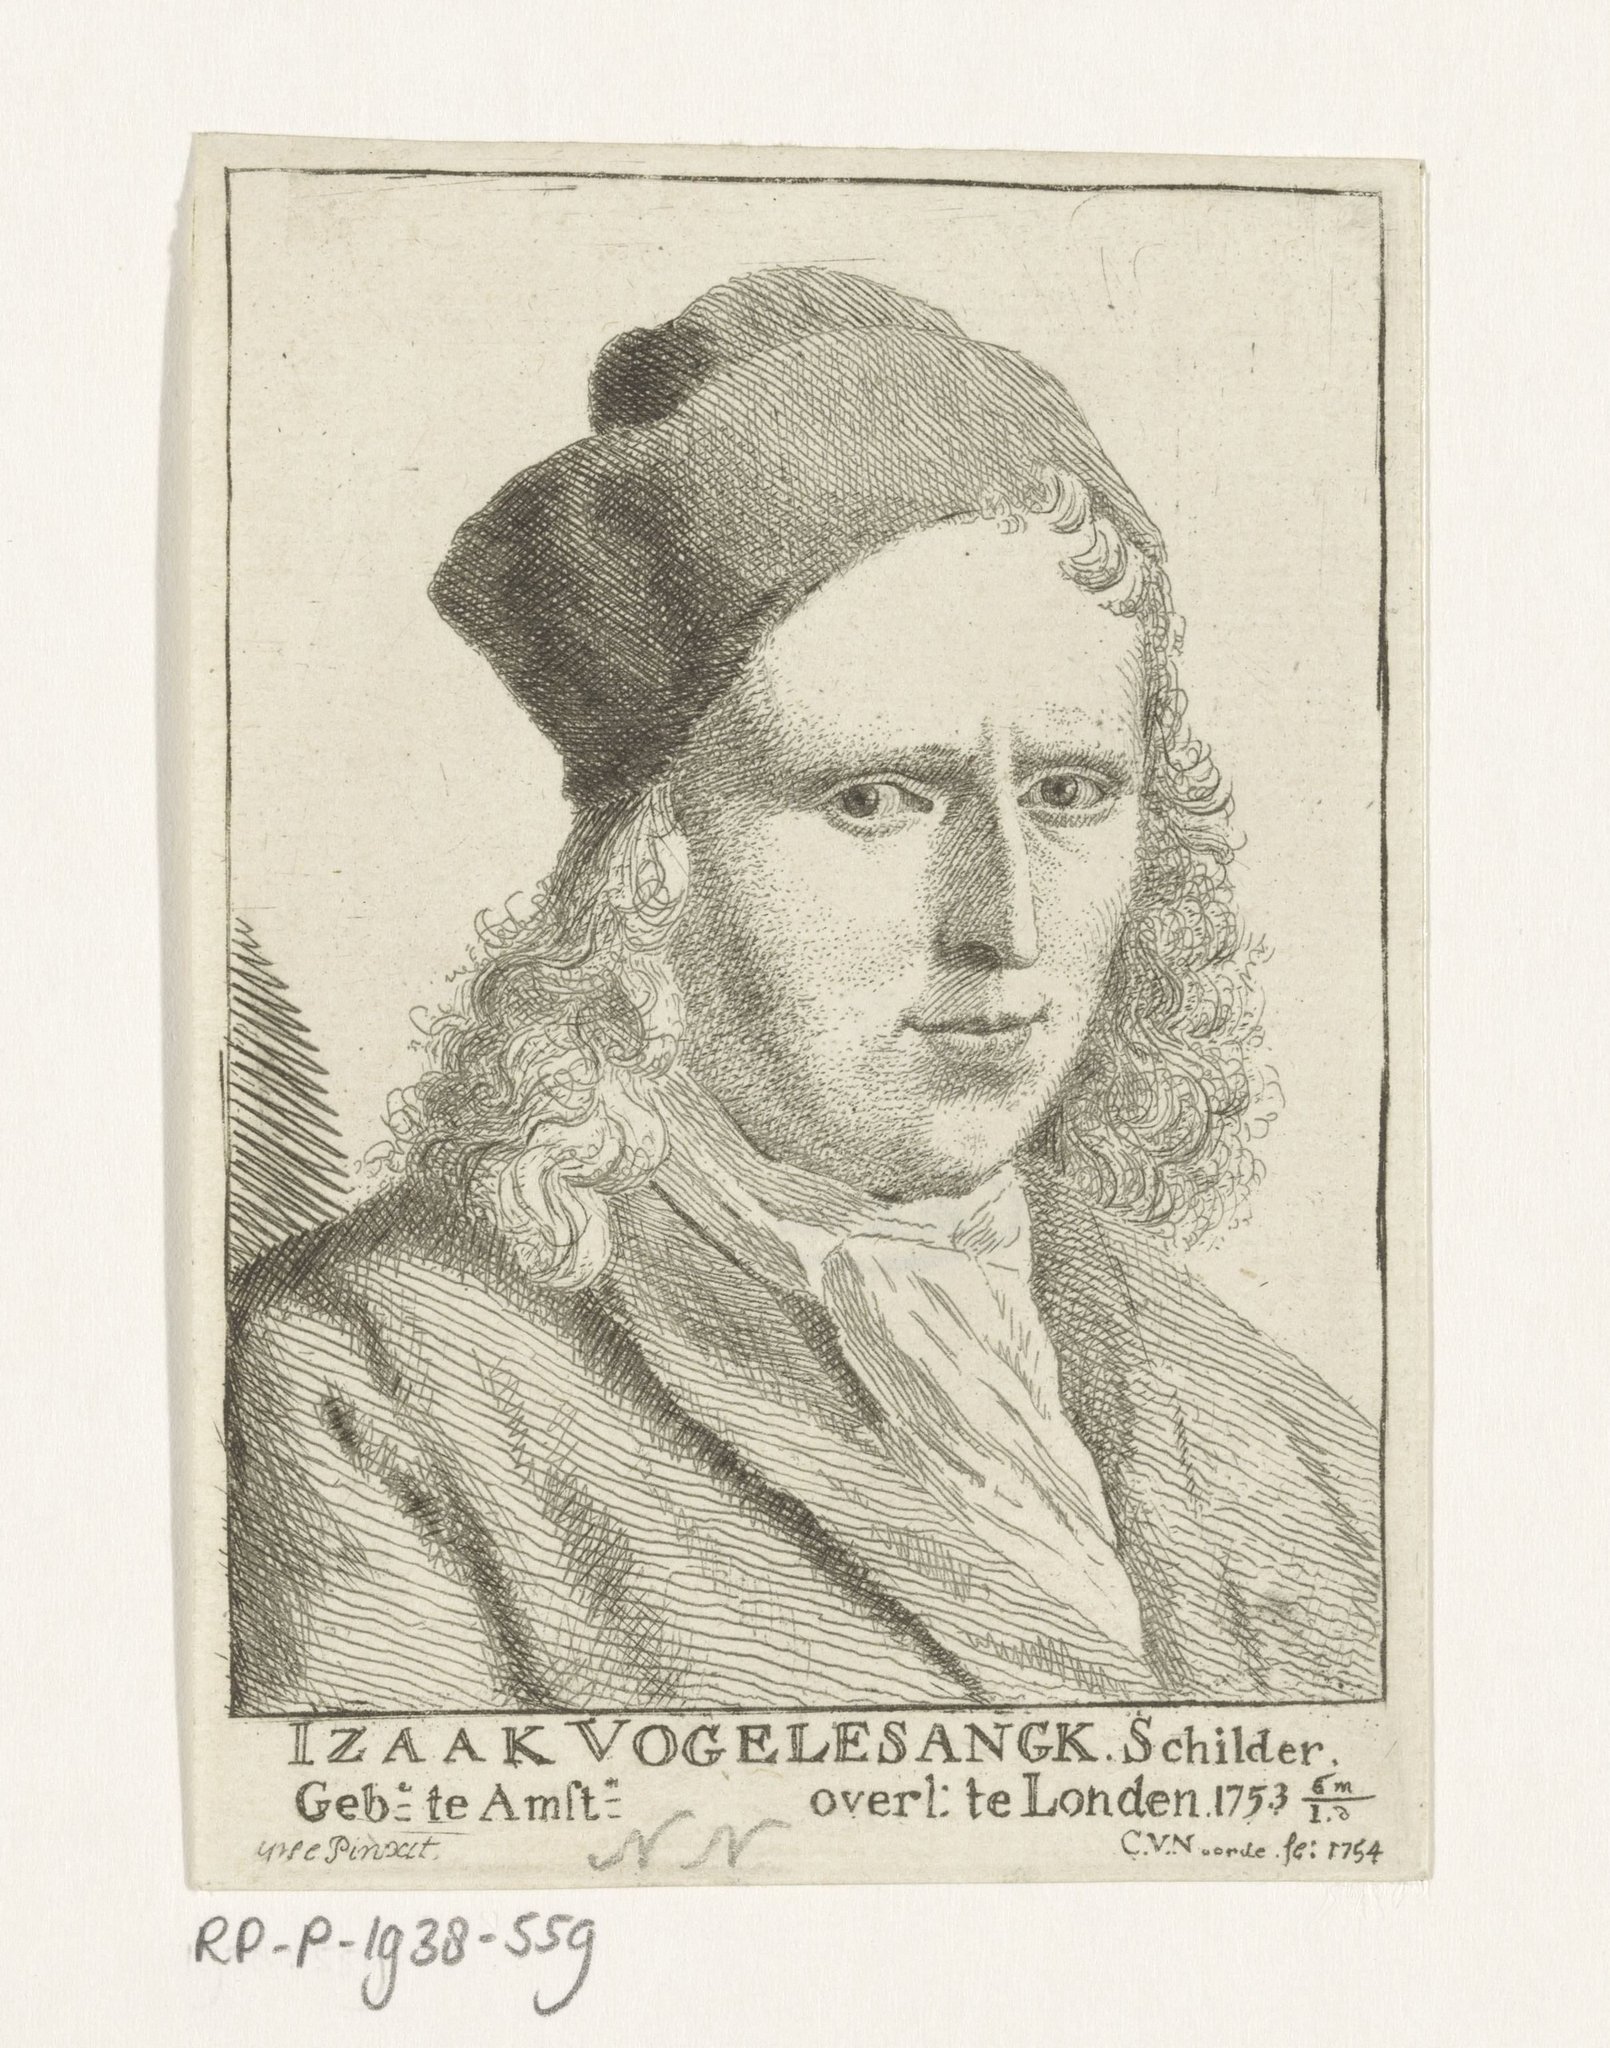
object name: print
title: Portret van Izaak Vogelensanck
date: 1754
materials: paper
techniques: etching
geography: haarlem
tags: amsterdam, london, painter, izaak vogelensanck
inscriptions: collector's mark: Lugt 2228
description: Portret van de schilder Izaak Vogelensanck.